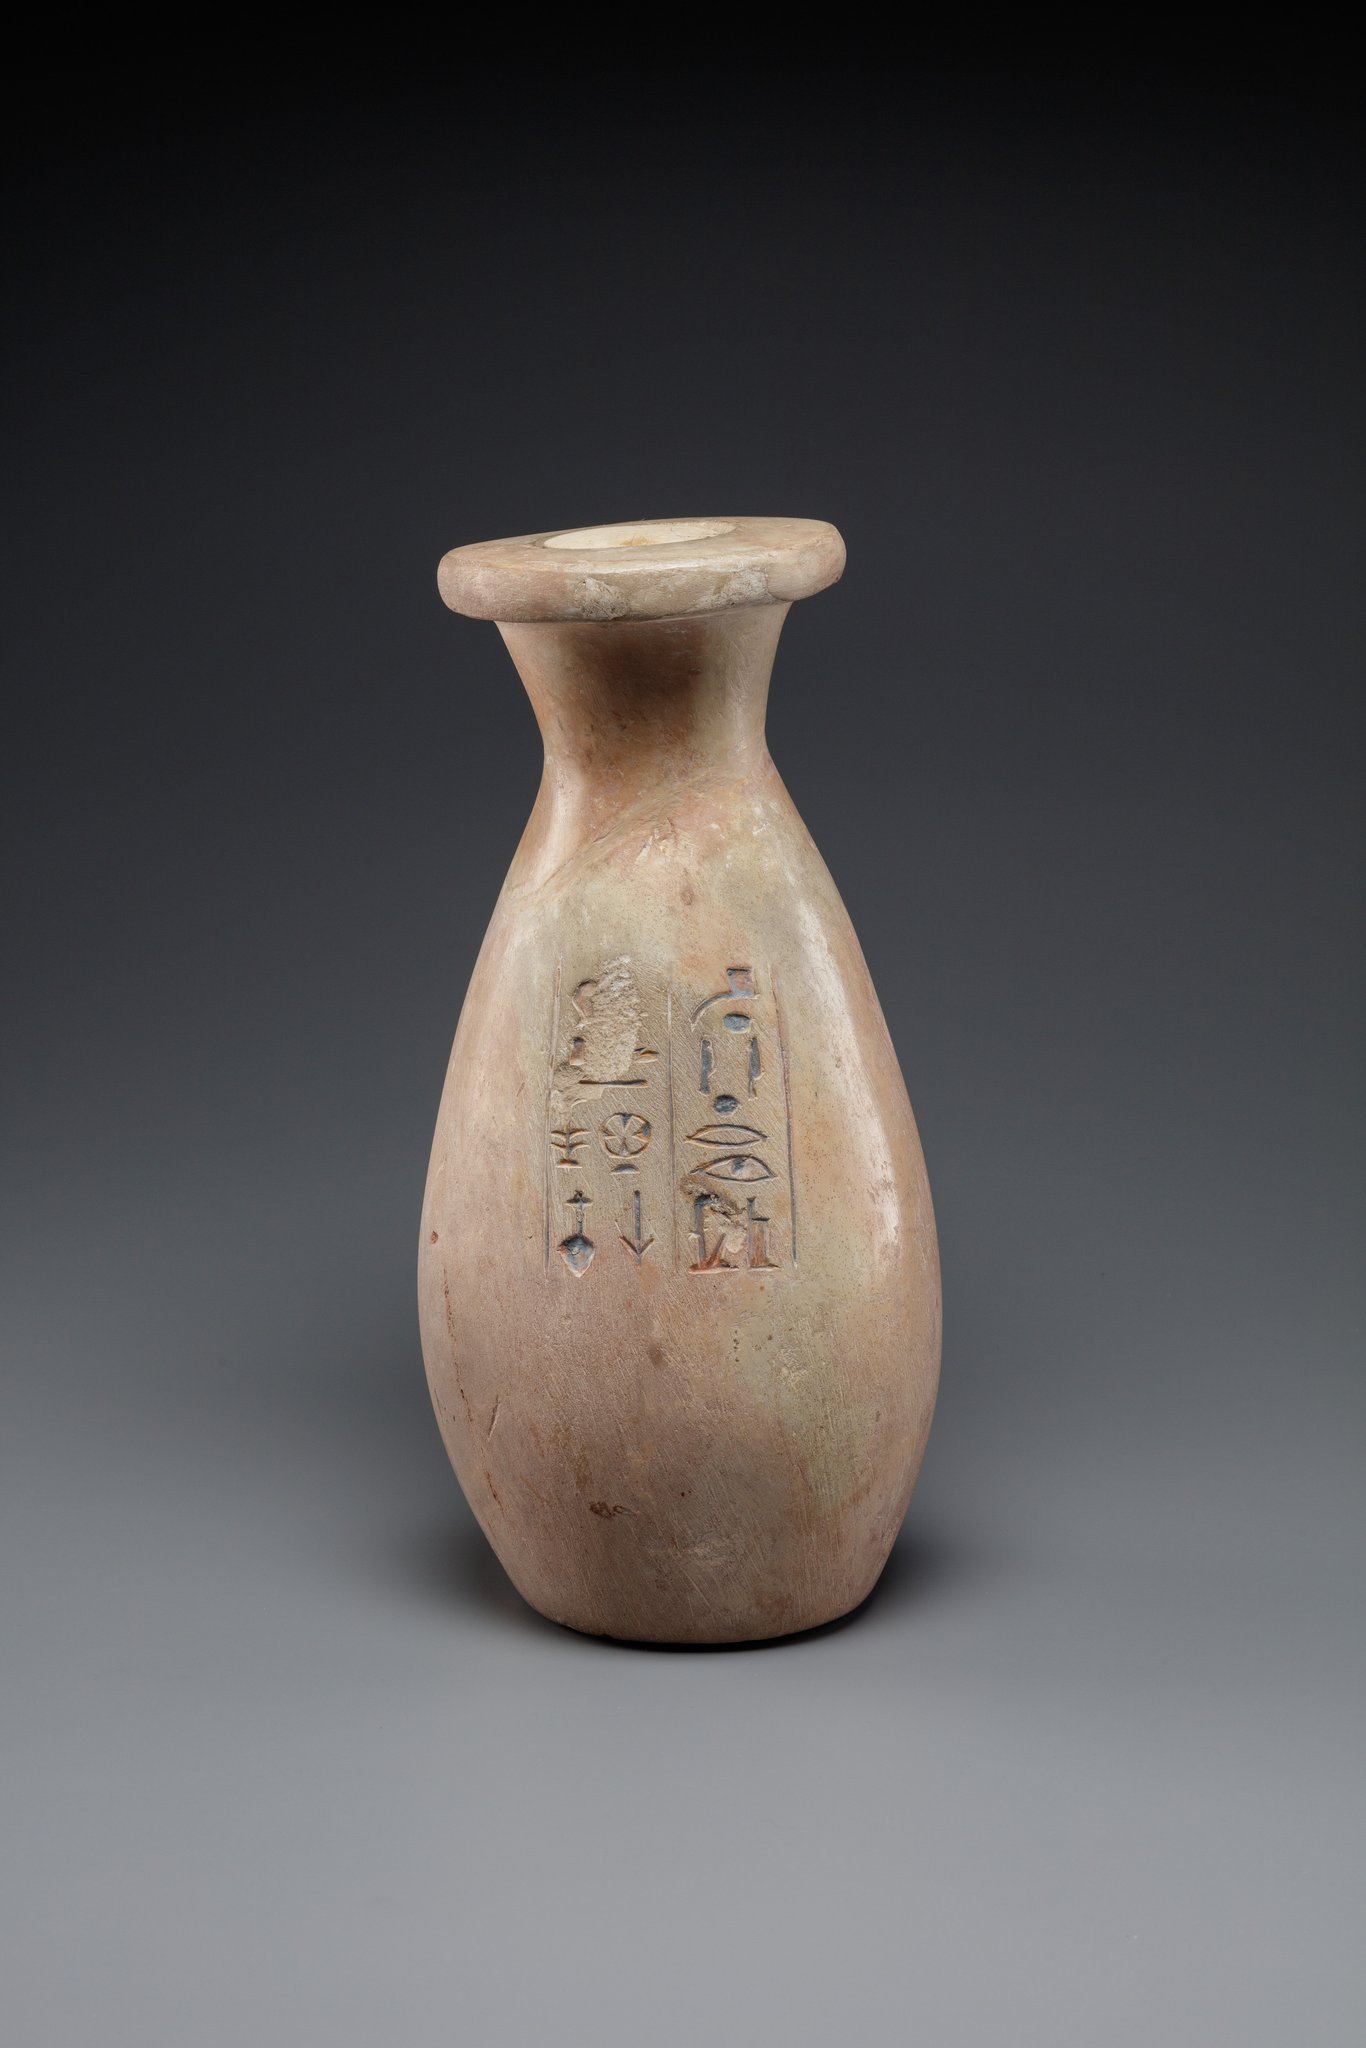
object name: jar, sennefer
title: Jar Inscribed for the Mayor of Thebes Sennefer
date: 1427-1400 BCE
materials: stone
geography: egypt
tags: hieroglyphs